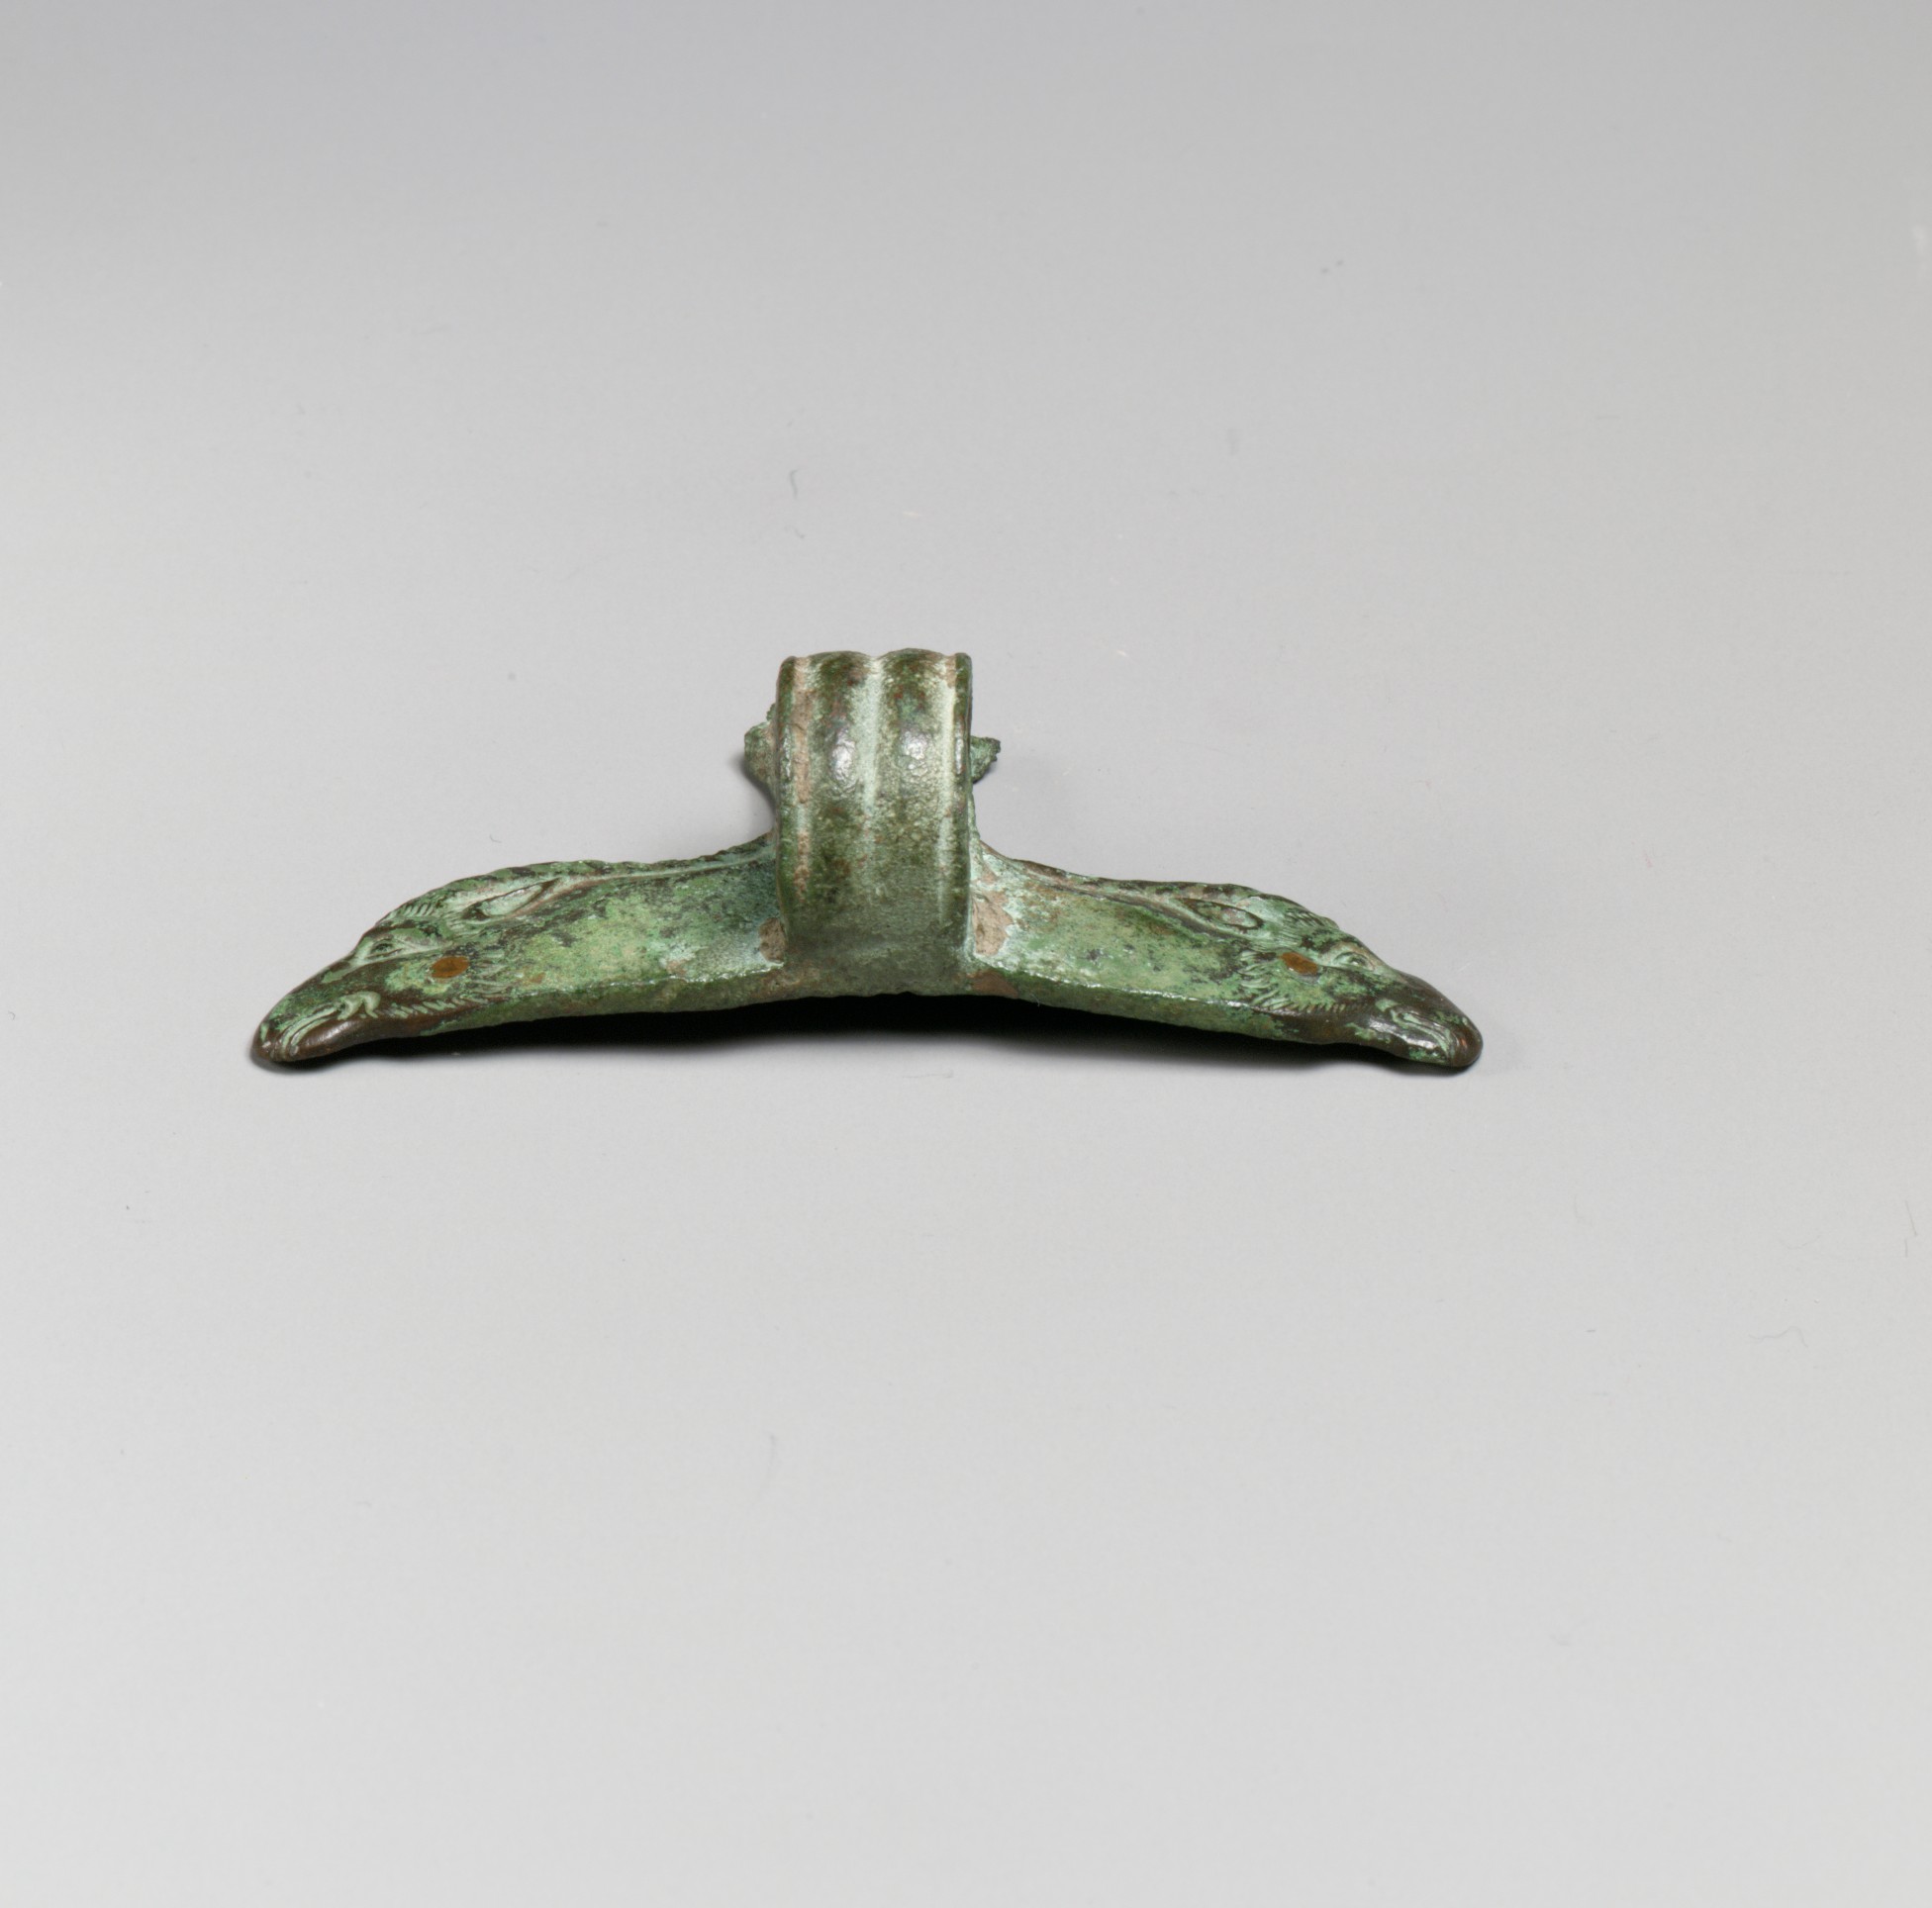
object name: handle attachment with antelope head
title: Bronze handle attachment with antelope heads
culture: greek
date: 300-101 BCE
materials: bronze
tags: antelope